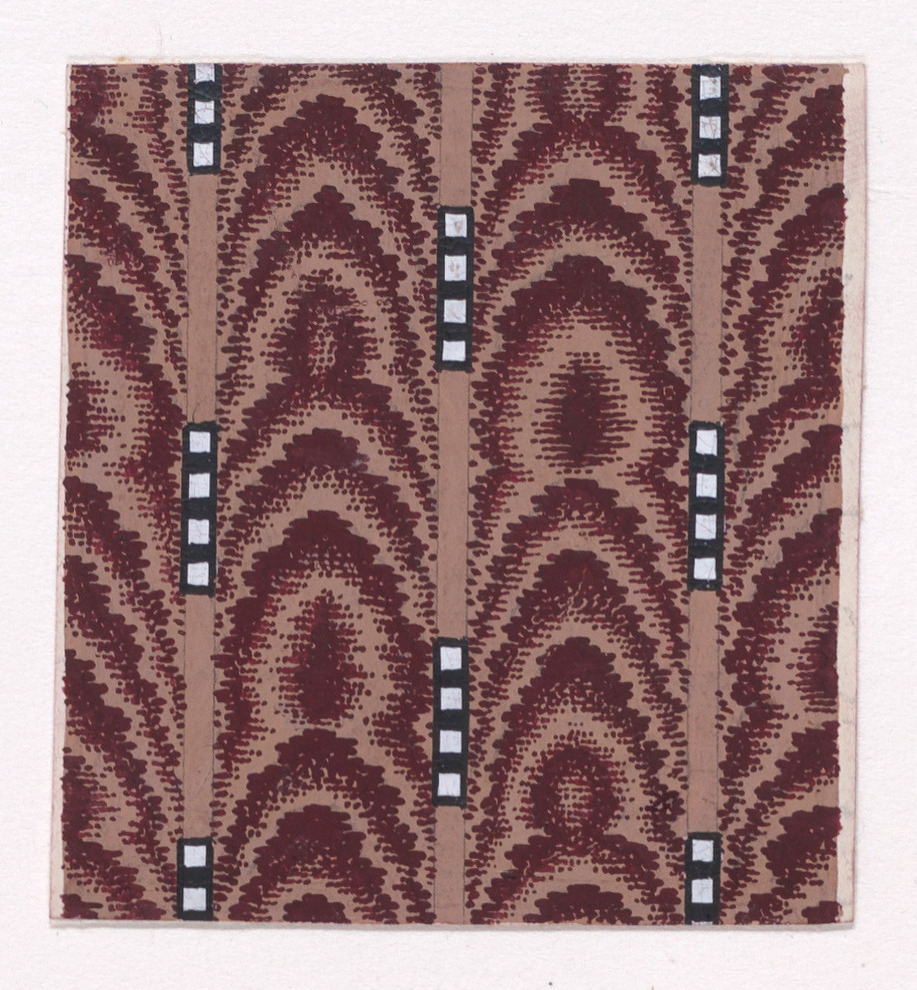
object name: drawing ornament architecture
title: Textile Design of Vertical Stripes of Overlapping Scales Simulating Tie-Dye Framed by Alternating Vertical Strings of Squares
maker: anonymous, alsatian, 19th century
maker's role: artist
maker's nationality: alsatian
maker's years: 1800-1900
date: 1840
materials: gouache